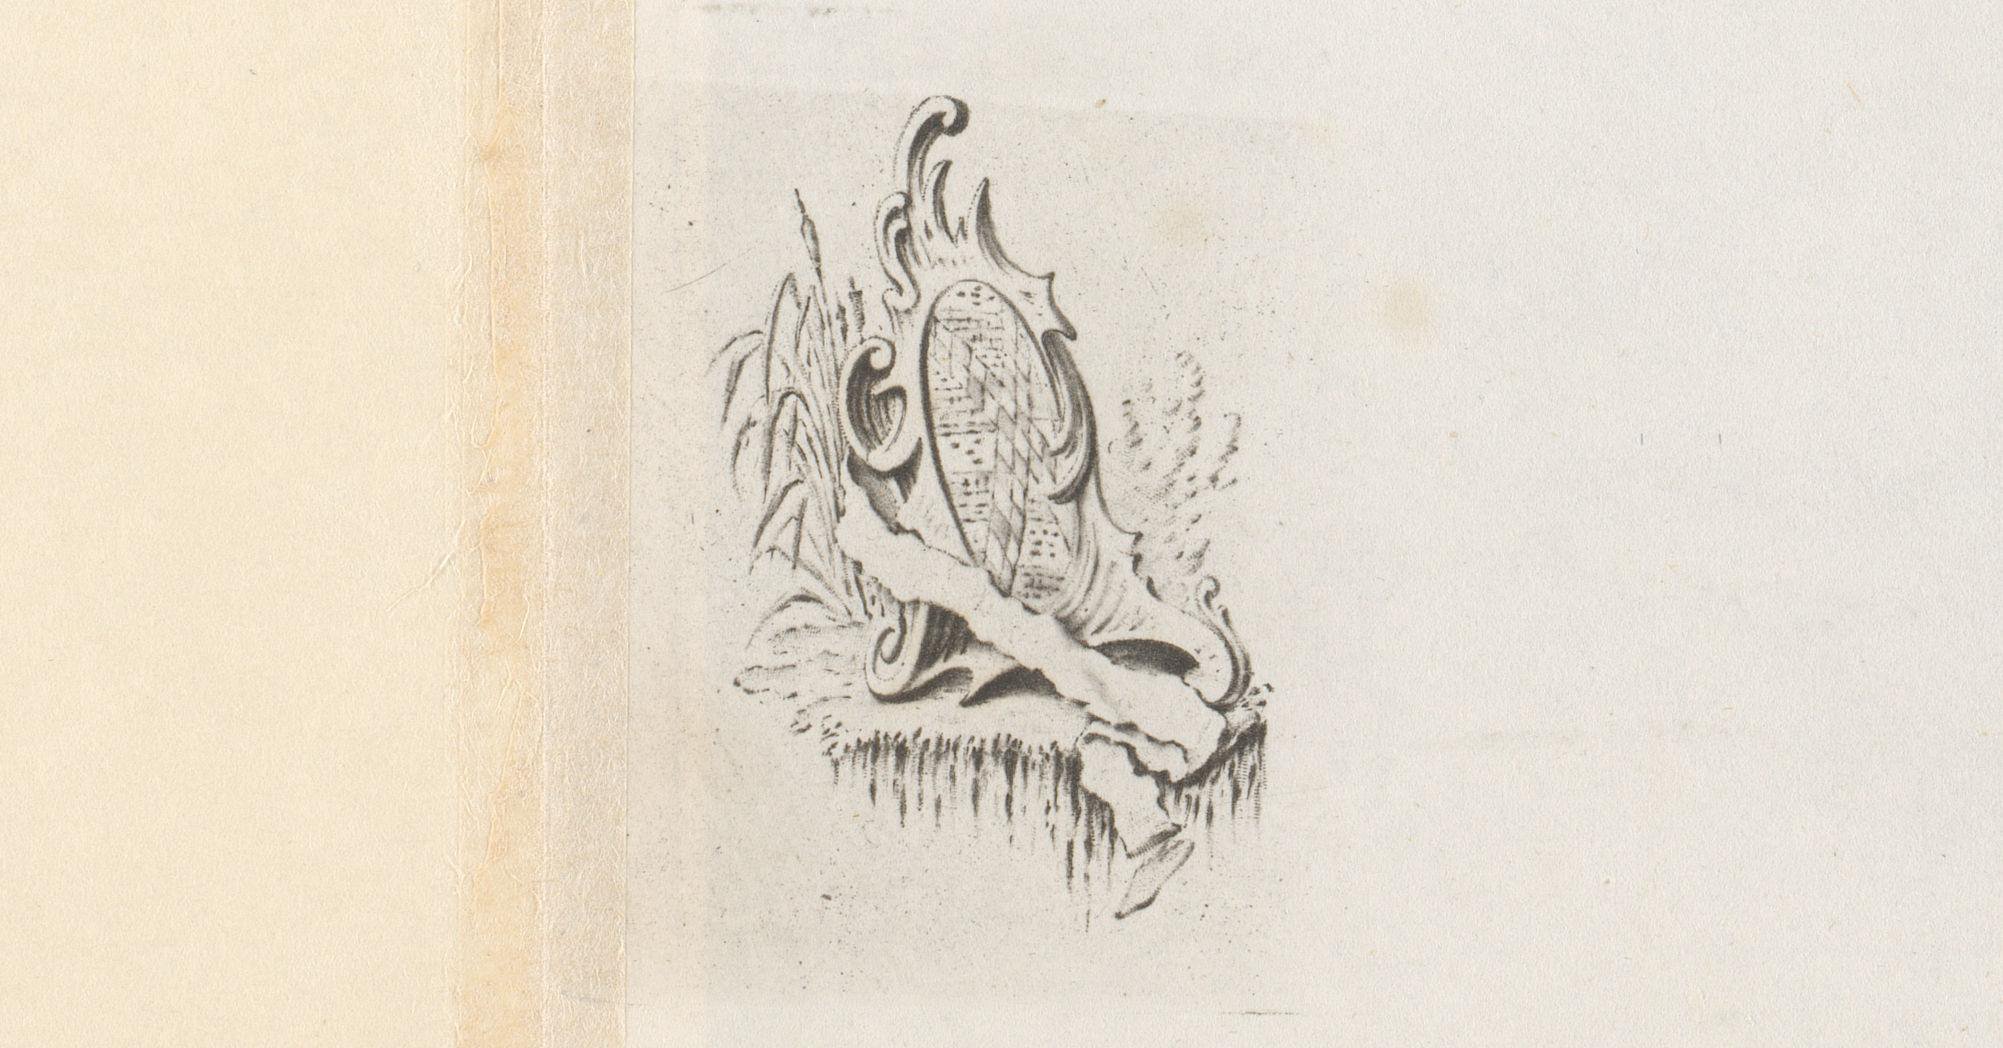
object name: print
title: Wapenmerk van Cornelis Ploos van Amstel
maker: cornelis ploos van amstel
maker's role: draughtsman, print maker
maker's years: 1726-1798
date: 1736-1798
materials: paper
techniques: printmaking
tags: print maker, draughtsman, cornelis ploos van amstel, armorial bearing, heraldry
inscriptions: collector's mark: Lugt 2166